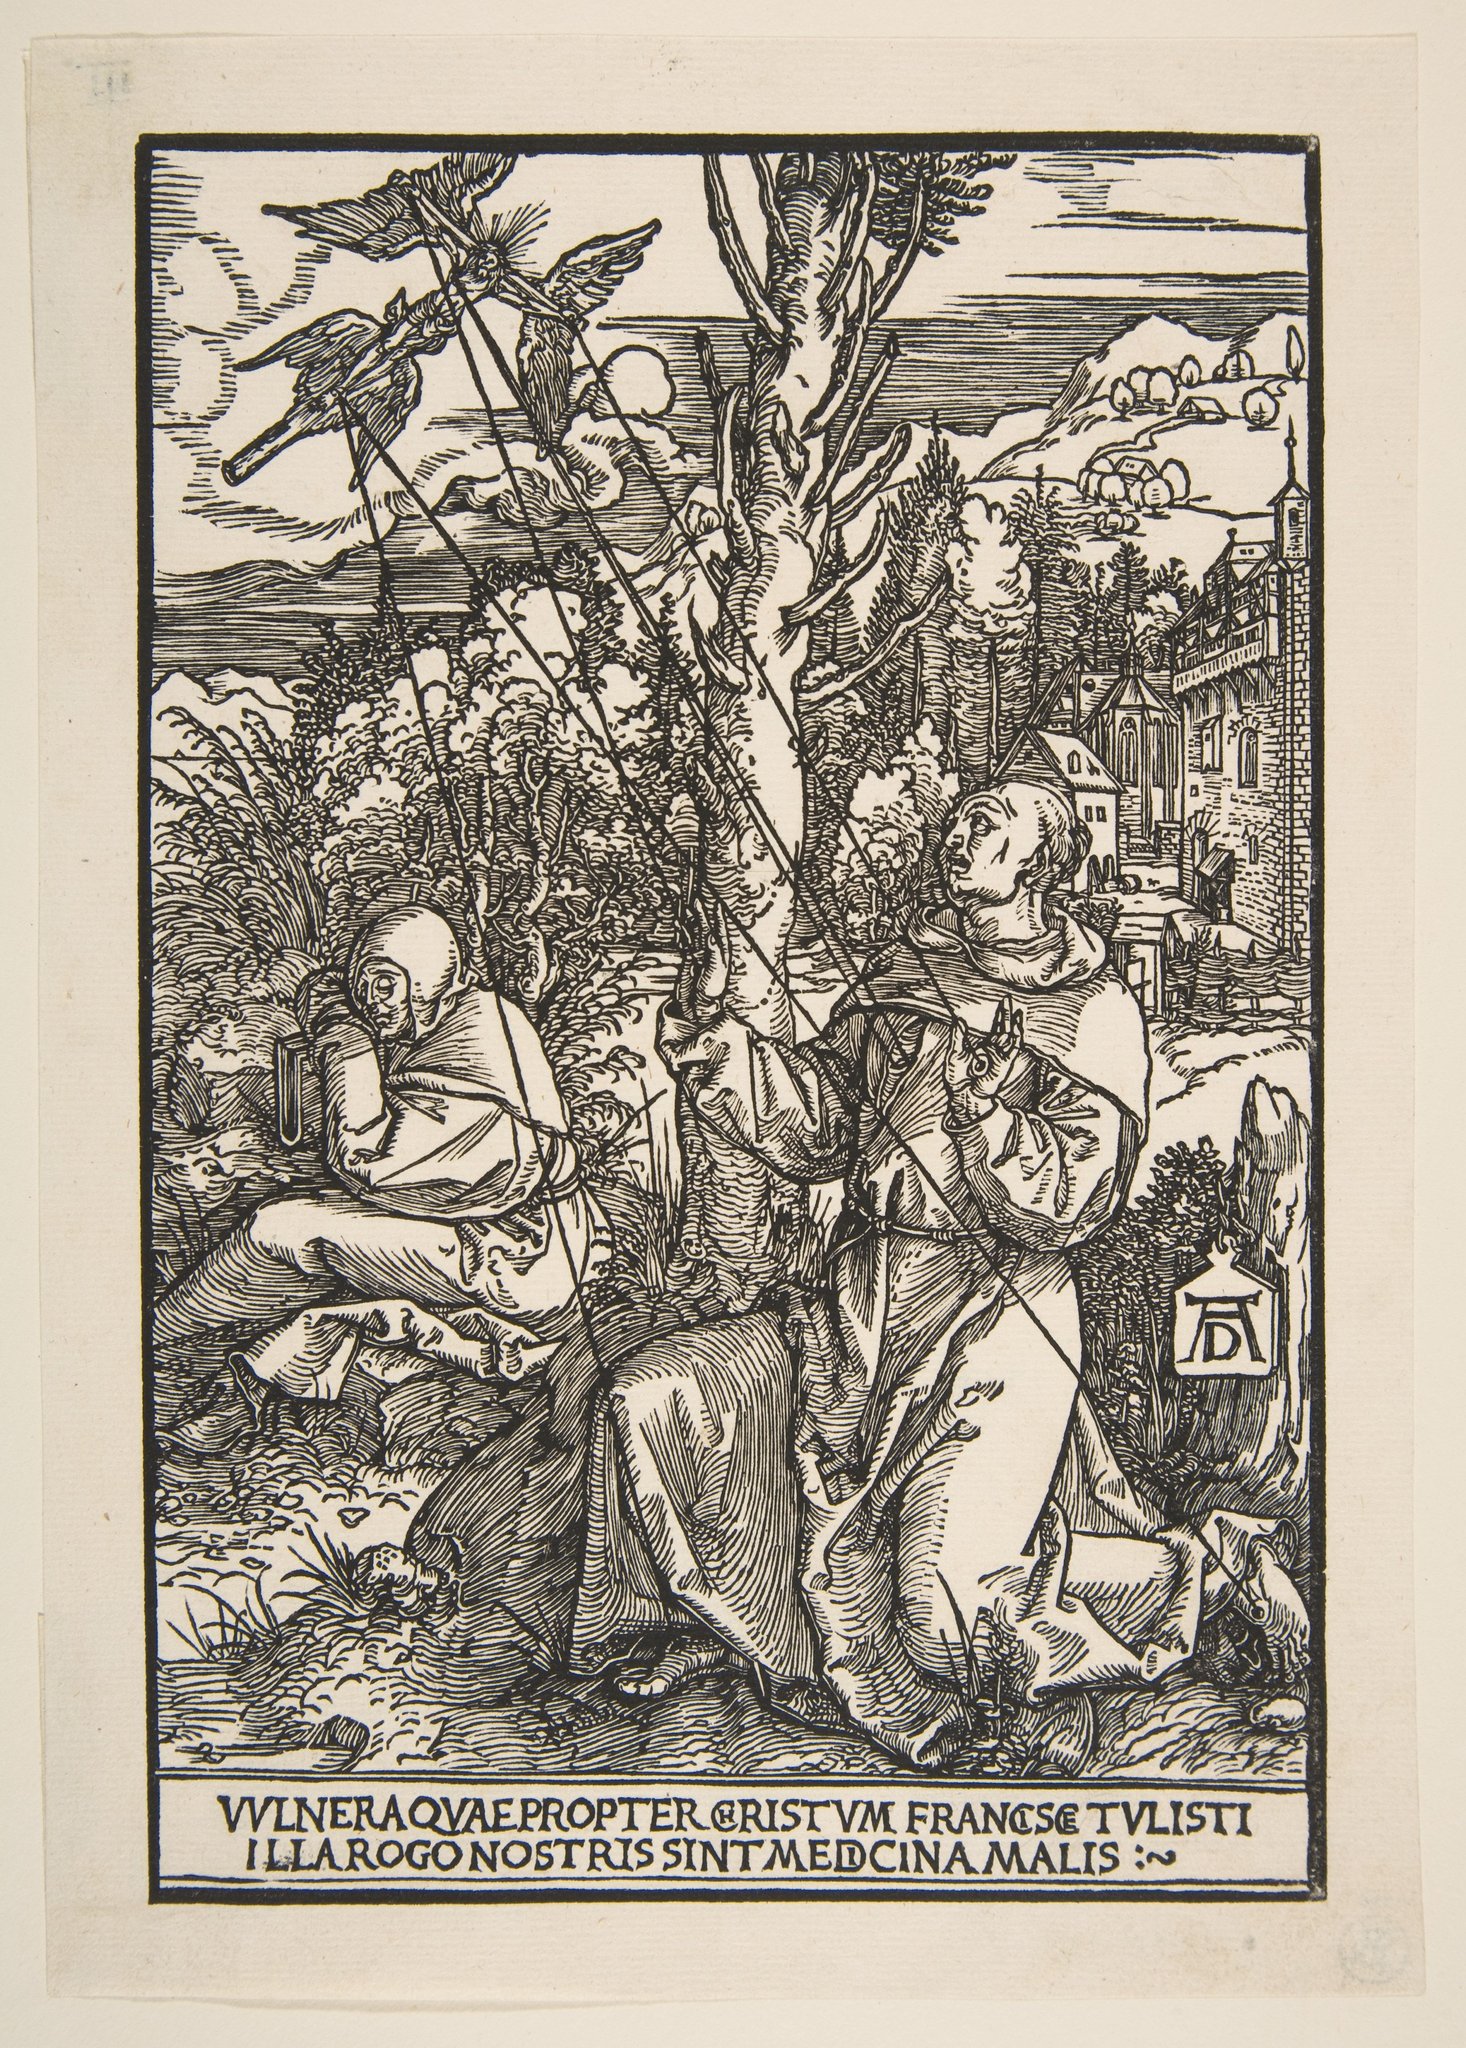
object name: print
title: Saint Francis Receiving the Stigmata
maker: albrecht dürer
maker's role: artist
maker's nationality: german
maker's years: 1471-1528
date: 1503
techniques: woodcut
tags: saint francis